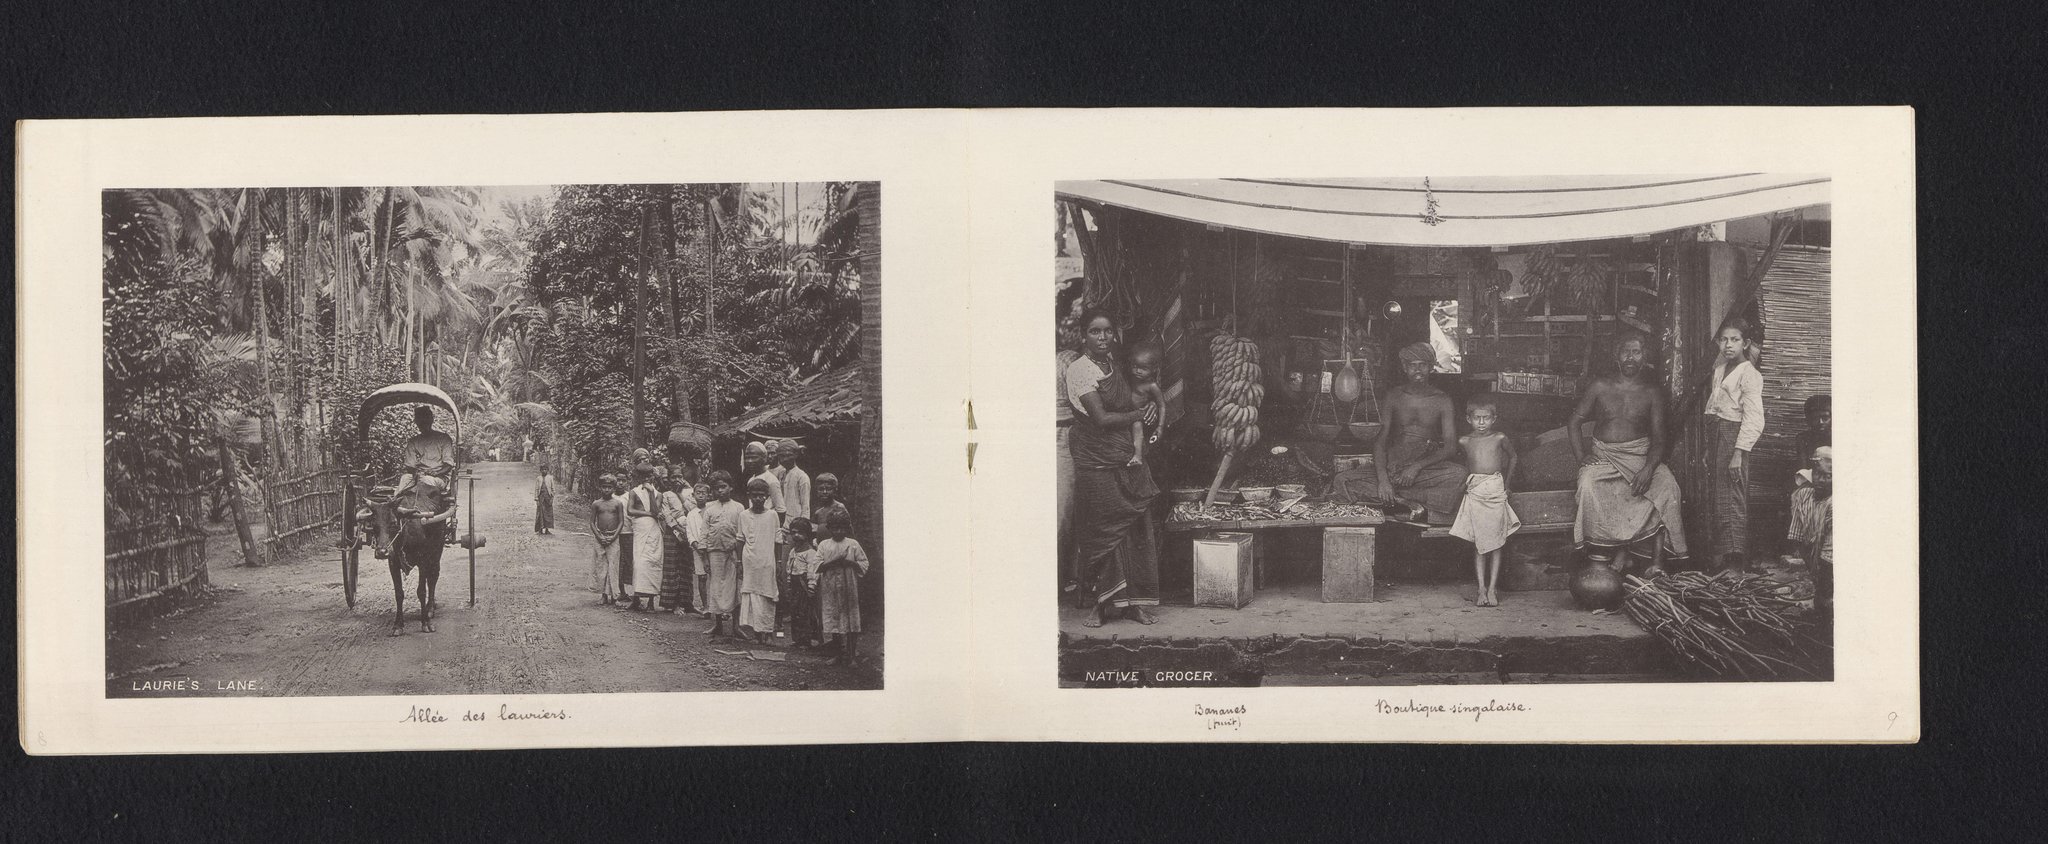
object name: page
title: Native grocer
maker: henry william cave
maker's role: fotograaf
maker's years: 1854-1913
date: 1890-1910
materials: paper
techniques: photograph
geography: colombo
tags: stall, booth (~ market)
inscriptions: inscription: ‘Bananes (fruit) Boutique singalaise’